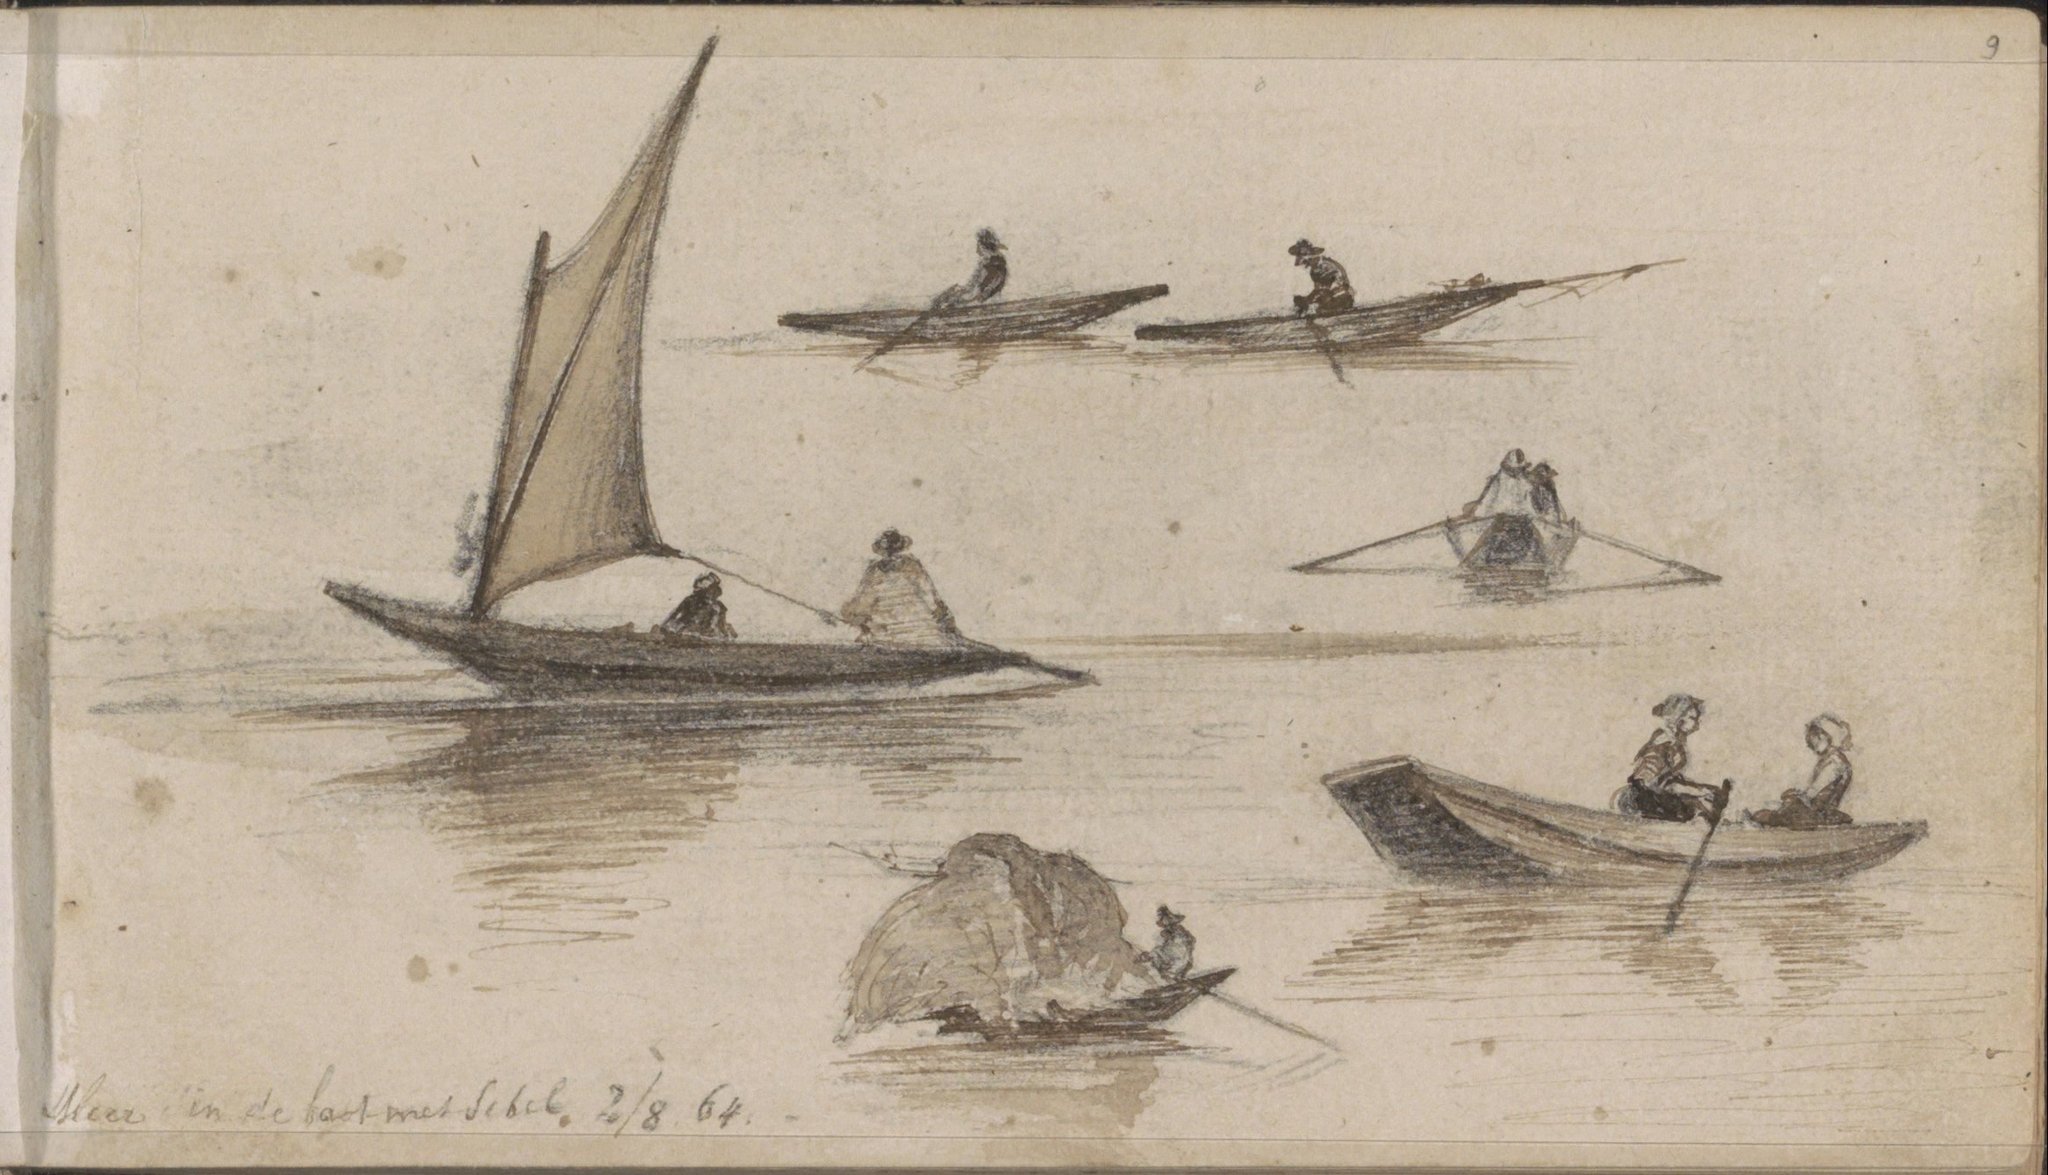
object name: sketchbook leaf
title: Figuren in roei- en zeilschepen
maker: johannes tavenraat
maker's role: draughtsman, painter, print maker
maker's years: 1809-1881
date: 1808-1864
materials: ink, paper, pencil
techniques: pen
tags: sailing-ship, sailing-boat, rowing-boat, canoe, etc., hay-stack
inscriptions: date and inscription: ‘Meer in de boot met Sebel 2/8 64.’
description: Onder andere een figuur in een roeiboot met een hooibaal. Blad 9 recto uit een schetsboek met 98 bladen.